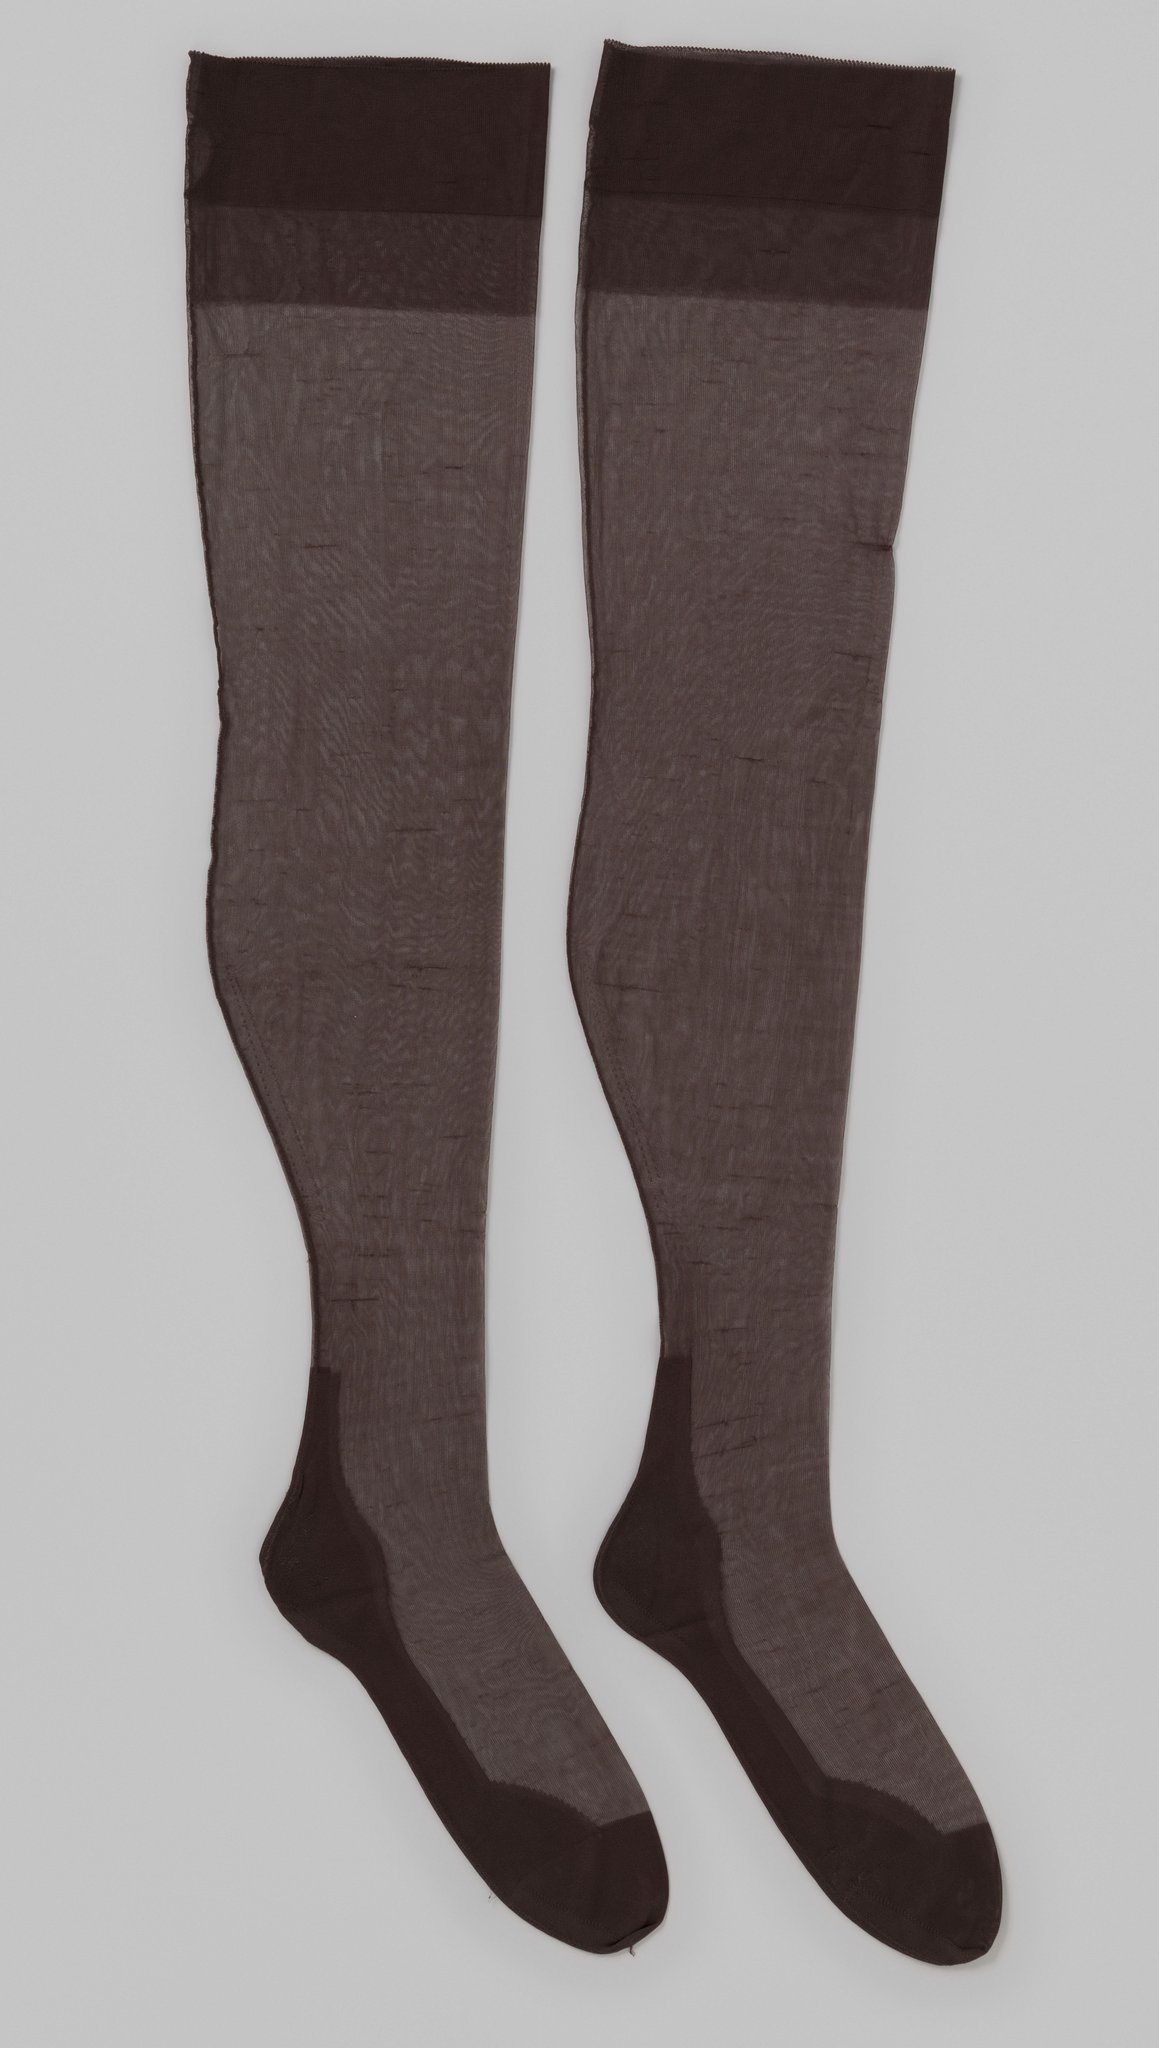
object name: stocking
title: Kous van effen donkergrijze nylon, bijna transparant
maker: Anonymous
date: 1955-1965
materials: plastic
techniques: knitting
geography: netherlands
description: Kous van effen donkergrijze nylon, bijna transparant, met dikkere zool, hiel. Naad middenachter. Dubbelgevouwen boord, met aan de achterkant binnenkant een opening.